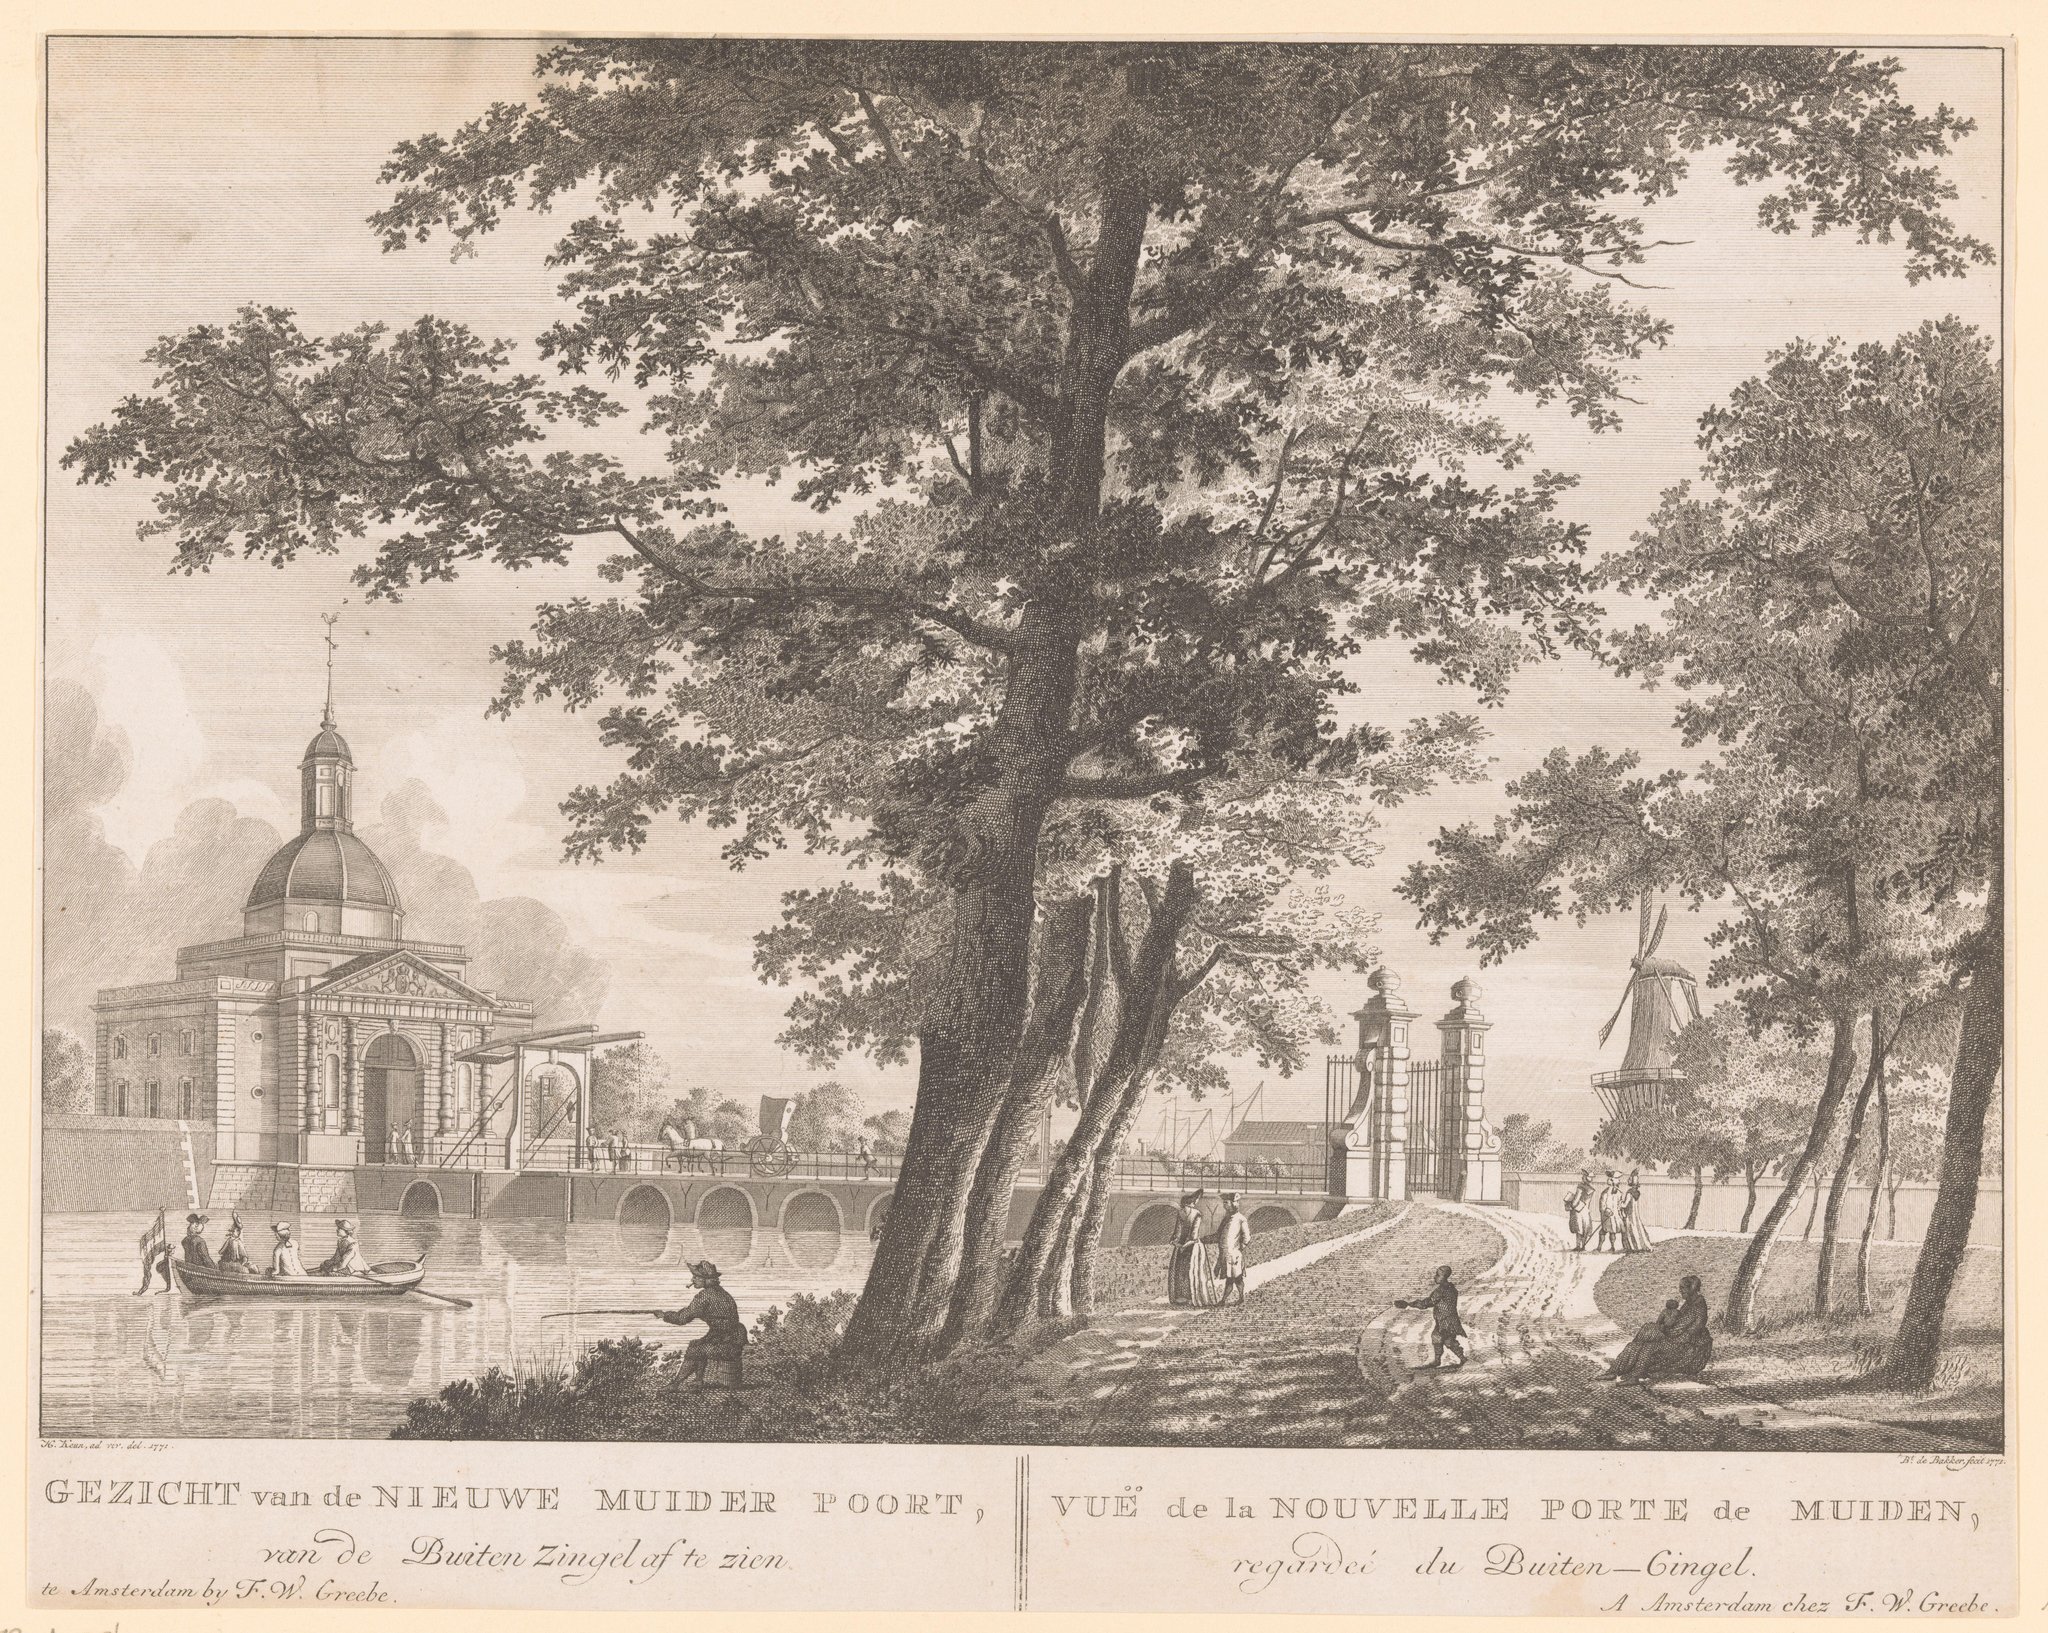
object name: print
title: Gezicht van de nieuwe Muider poort, van de Buiten Zingel af te zien / Vuë de la nouvelle porte de Muiden, regardeé du Buiten-Cingel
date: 1771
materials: paper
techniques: engraving, etching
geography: amsterdam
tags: rowing facing backward, pulling, bridge in city across river, canal, etc., city-gate, angling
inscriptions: date